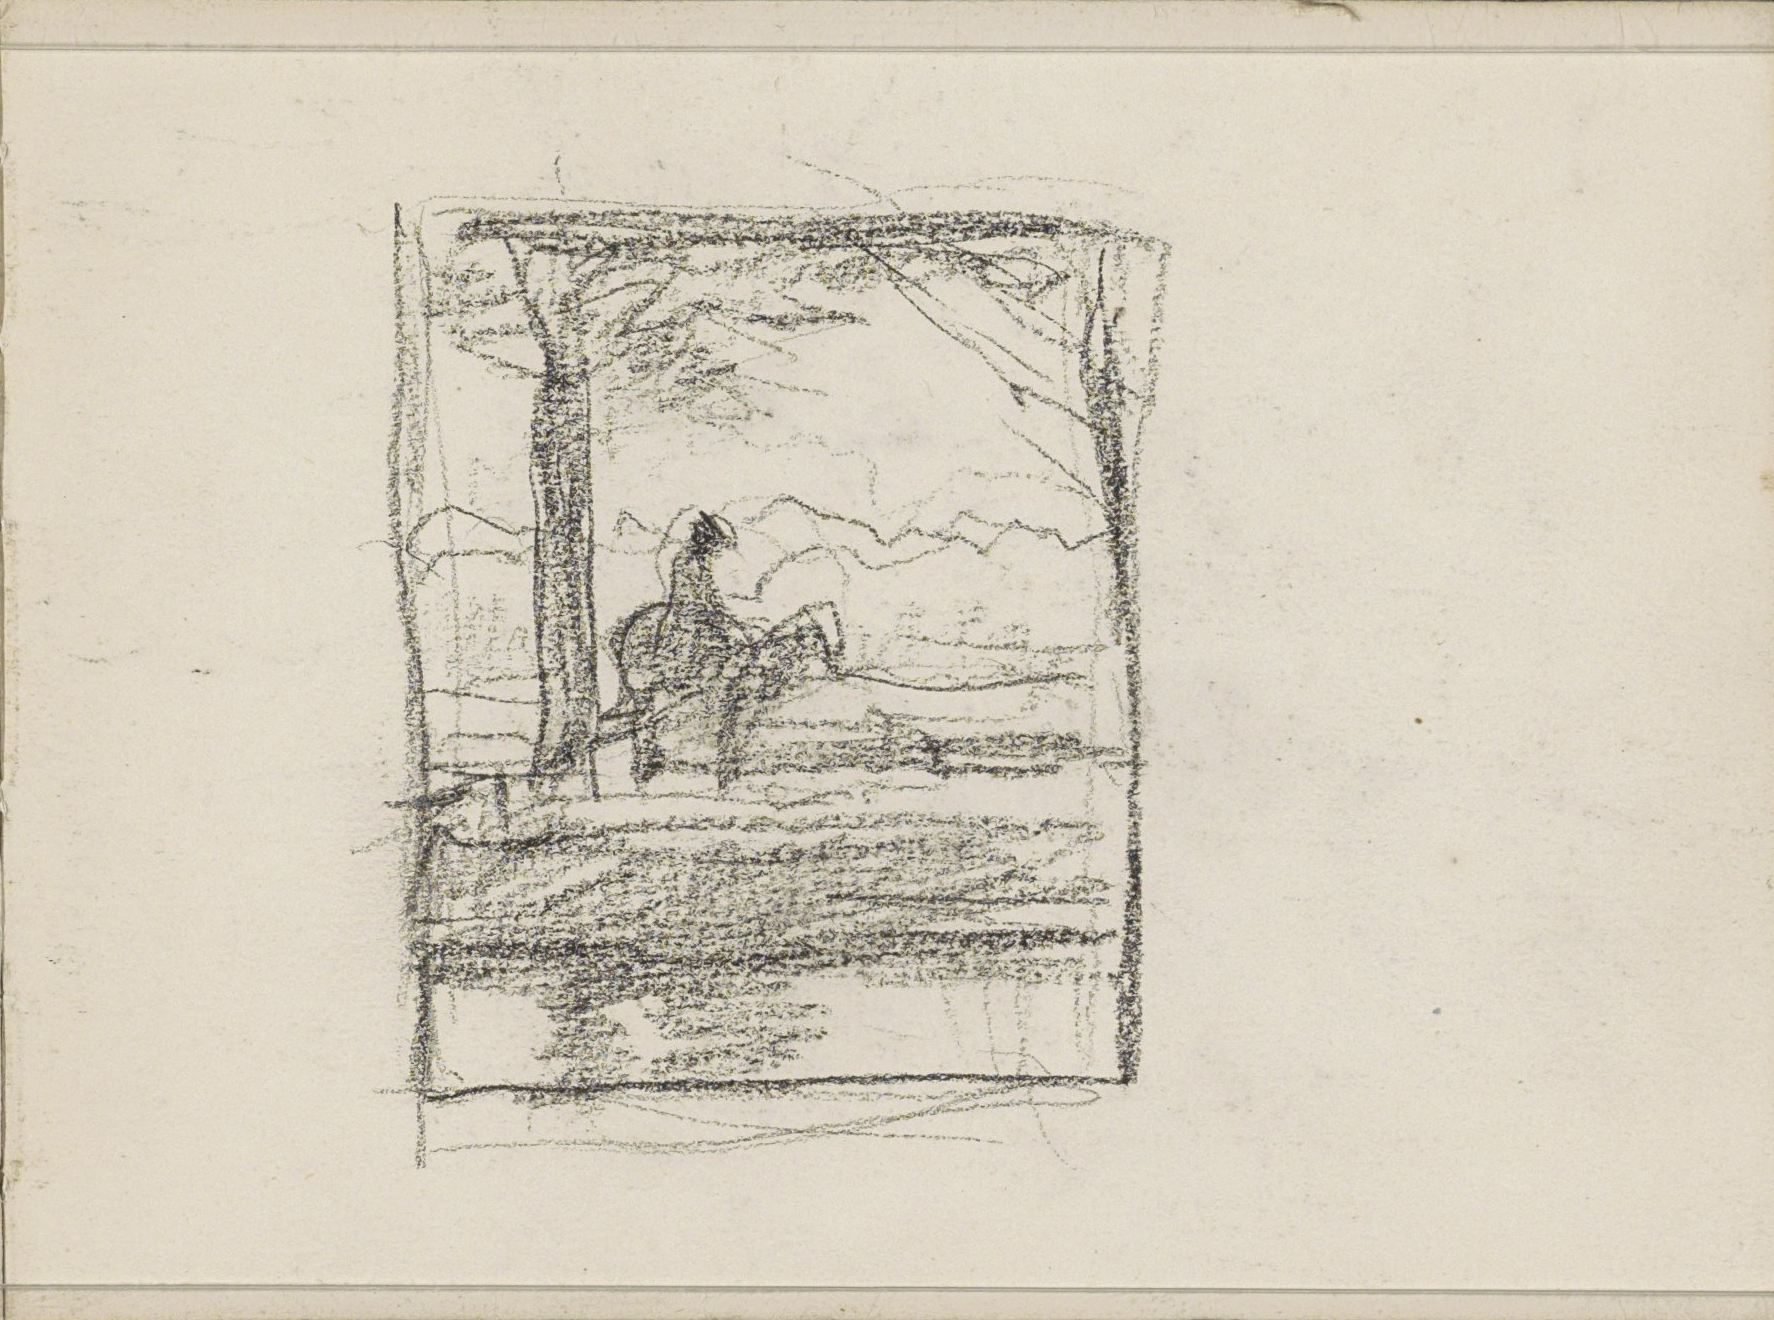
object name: sketchbook leaf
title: Ruiter bij een boom aan een waterkant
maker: anton mauve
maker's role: draughtsman, painter, print maker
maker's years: 1838-1888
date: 1848-1888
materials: chalk, paper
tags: riding a horse, ass, or mule; rider, horseman, landscapes with waters, waterscapes, seascapes (in the temperate zone) (+ landscape with figures, staffage)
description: Blad 28 recto uit een schetsboek met 33 bladen.